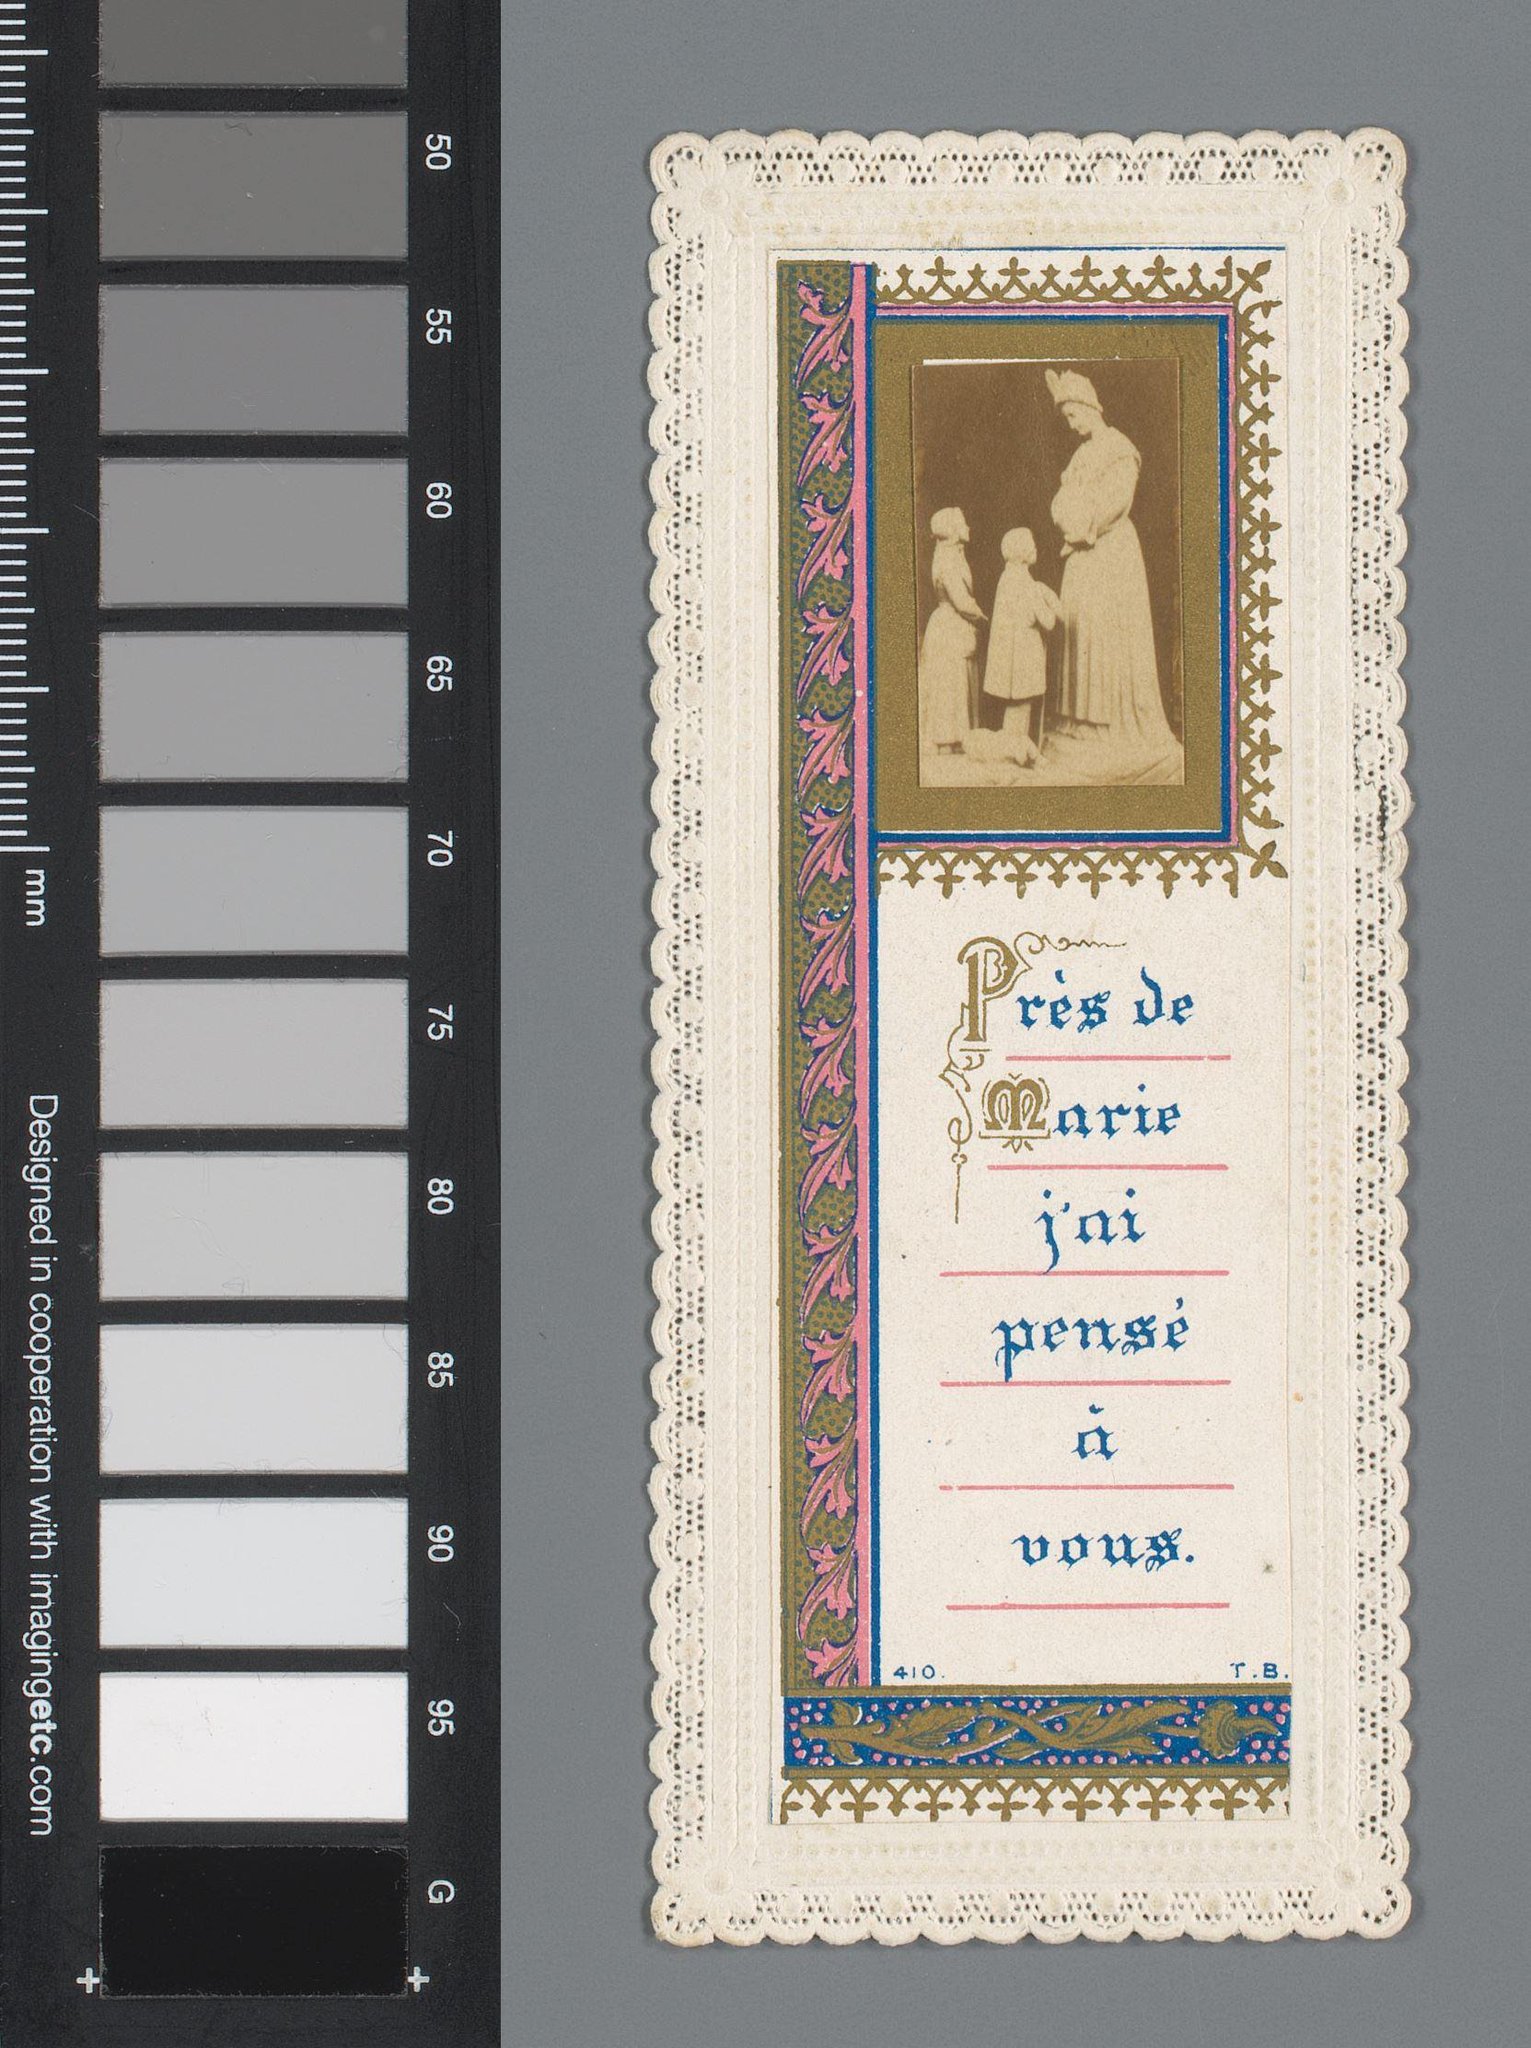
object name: photograph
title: Fotoreproductie van een schilderij van een onbekende geestelijke met twee kinderen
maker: Anonymous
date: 1851-1900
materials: paint, paper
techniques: albumen print, gilding, hand coloring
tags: child, organization, functionaries and dignitaries in roman catholic church; clergy in general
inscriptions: inscription: ‘Près de/ Marie/ j'ai/ pensé/ à/ vous./ 410. T.B.’